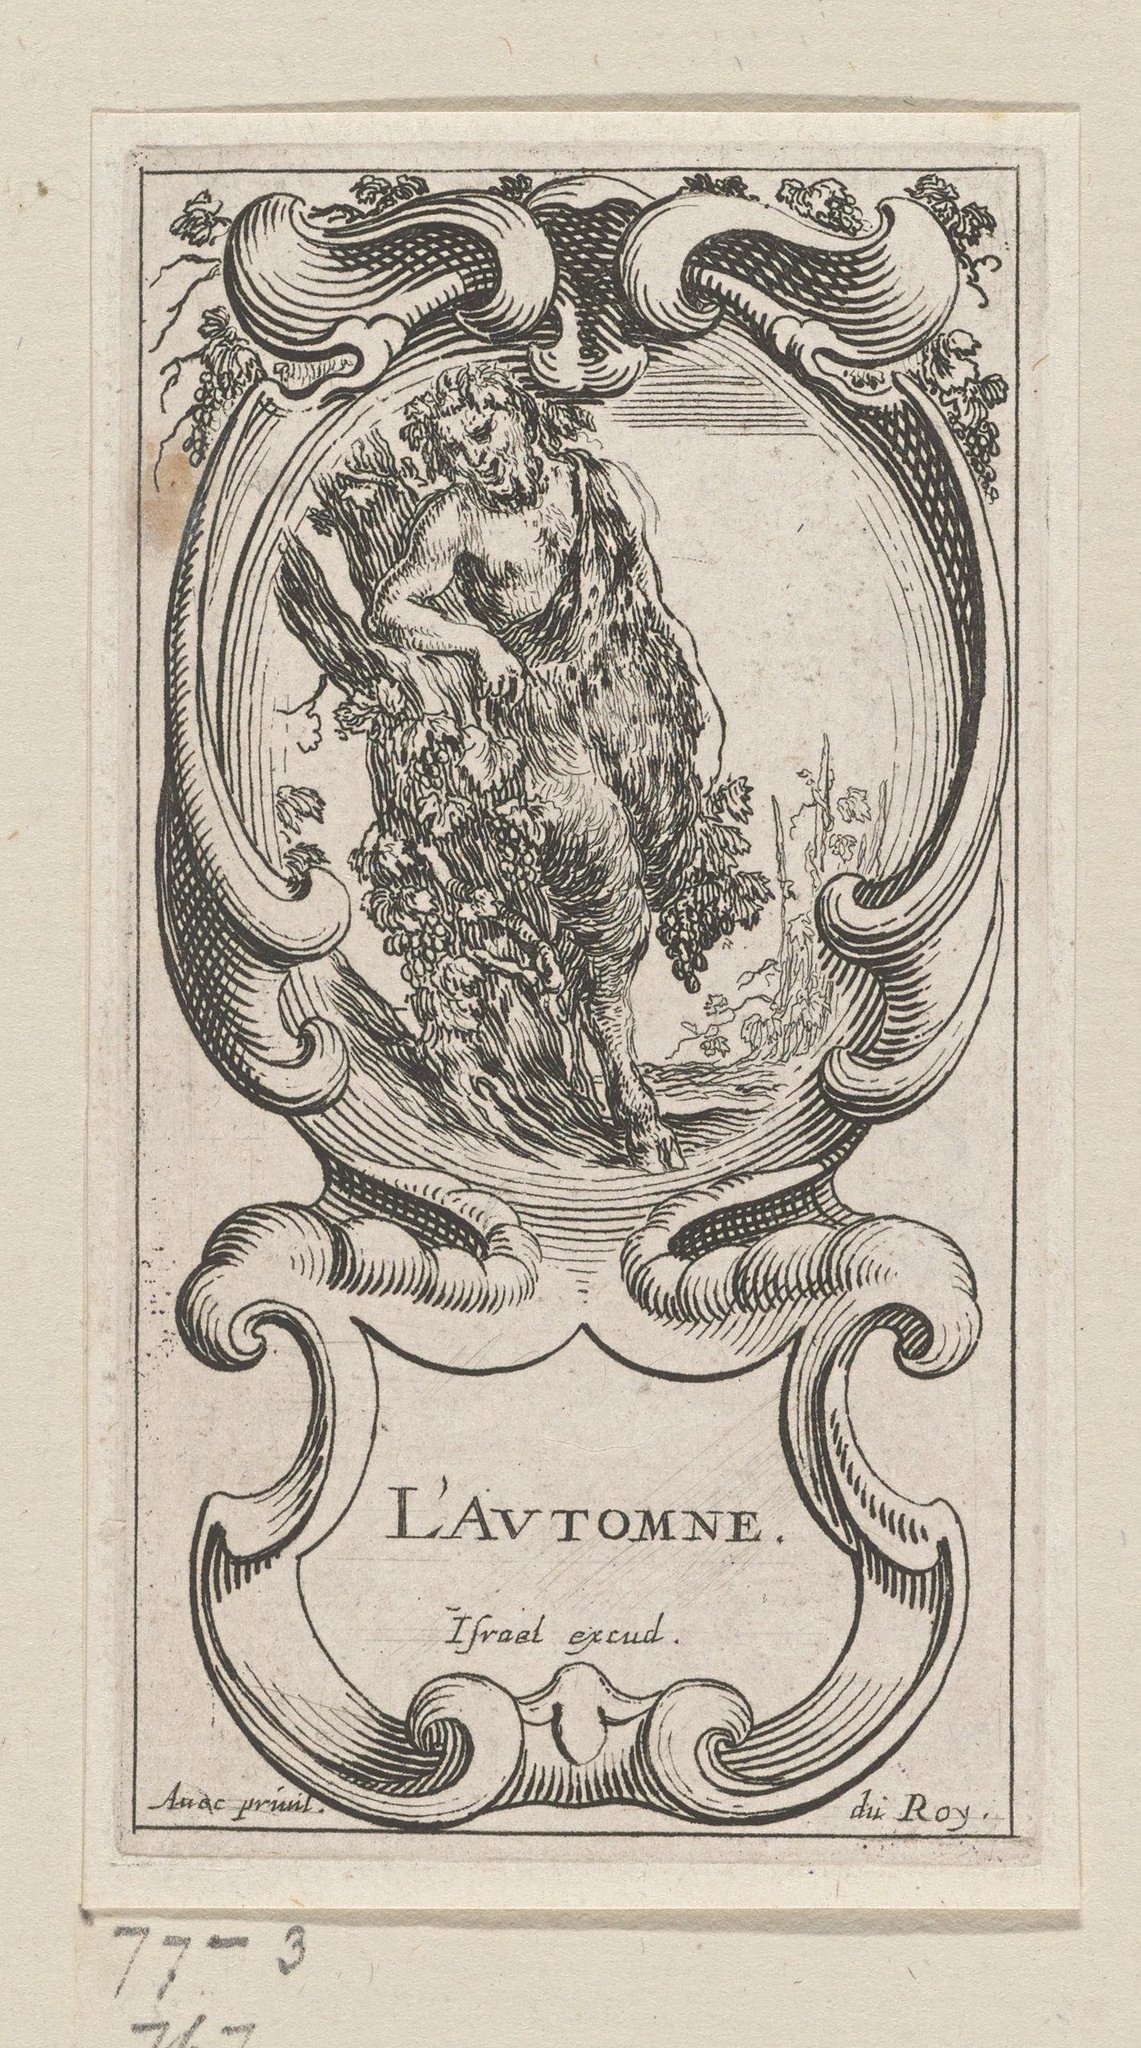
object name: print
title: Vier seizoenen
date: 1620-1664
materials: paper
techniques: etching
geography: paris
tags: satyr(s) (in general), autumn, fall, 'autumnus'; 'autunno' (ripa)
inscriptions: collector's mark: Lugt 240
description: Een sater leunend tegen een stam met druivenranken (personificatie van de herfst) gevat in een cartouche.